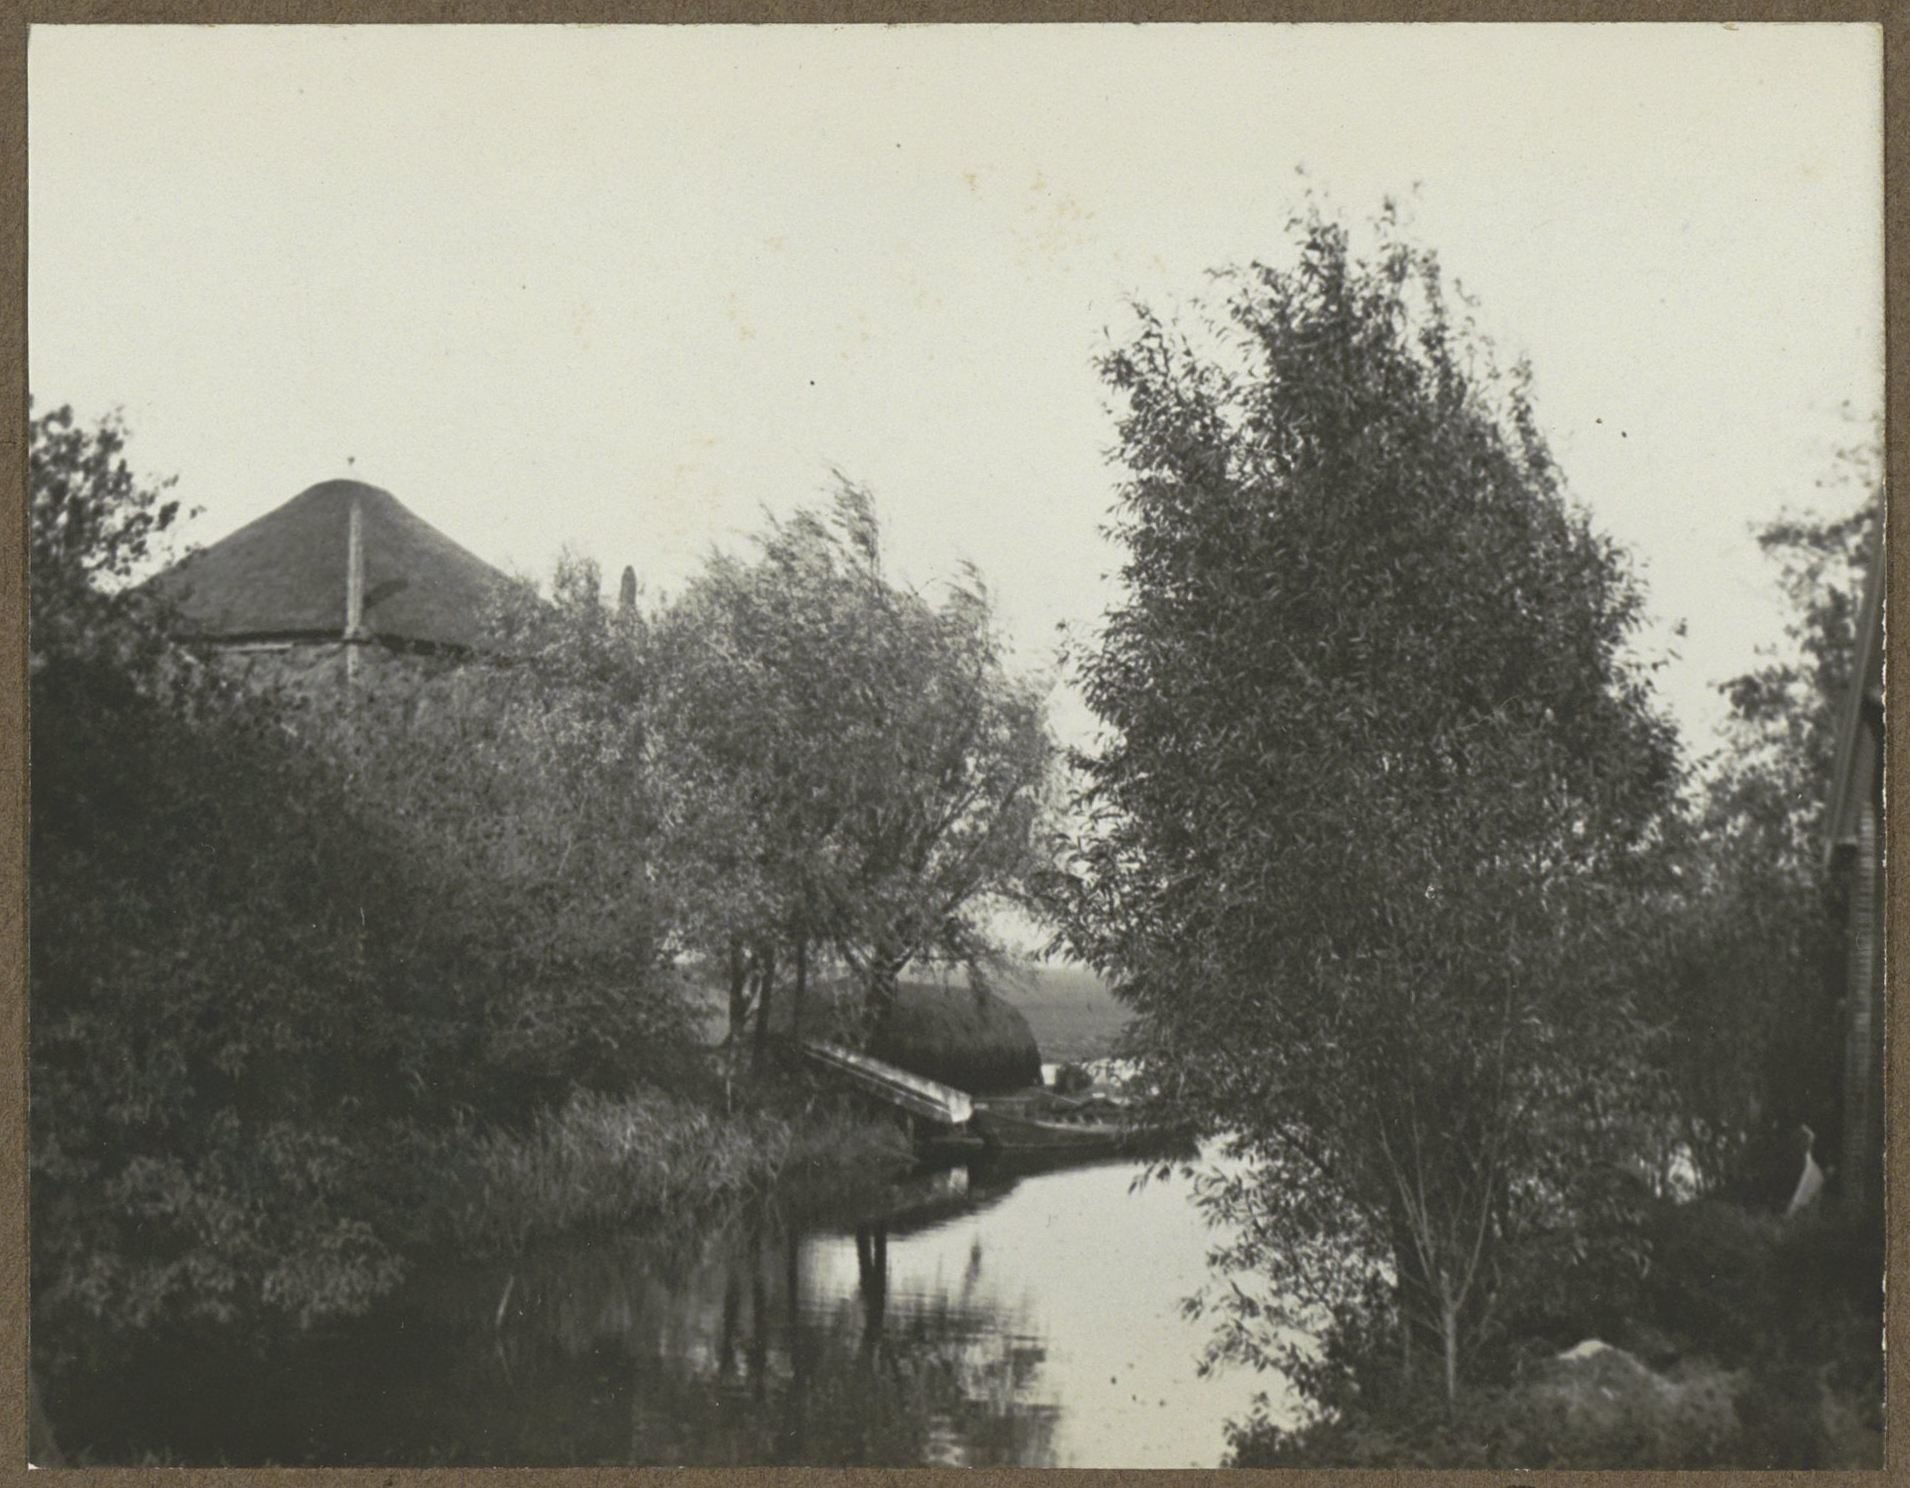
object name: photograph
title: Boerderij met sloot aan de Sloterweg te Sloten (NH)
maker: Anonymous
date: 1910-1935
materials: paper, photographic support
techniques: gelatin silver print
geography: sloten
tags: small canal, ditch, farm (building)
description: Onderdeel van Album met foto's van Amsterdam en omgeving.